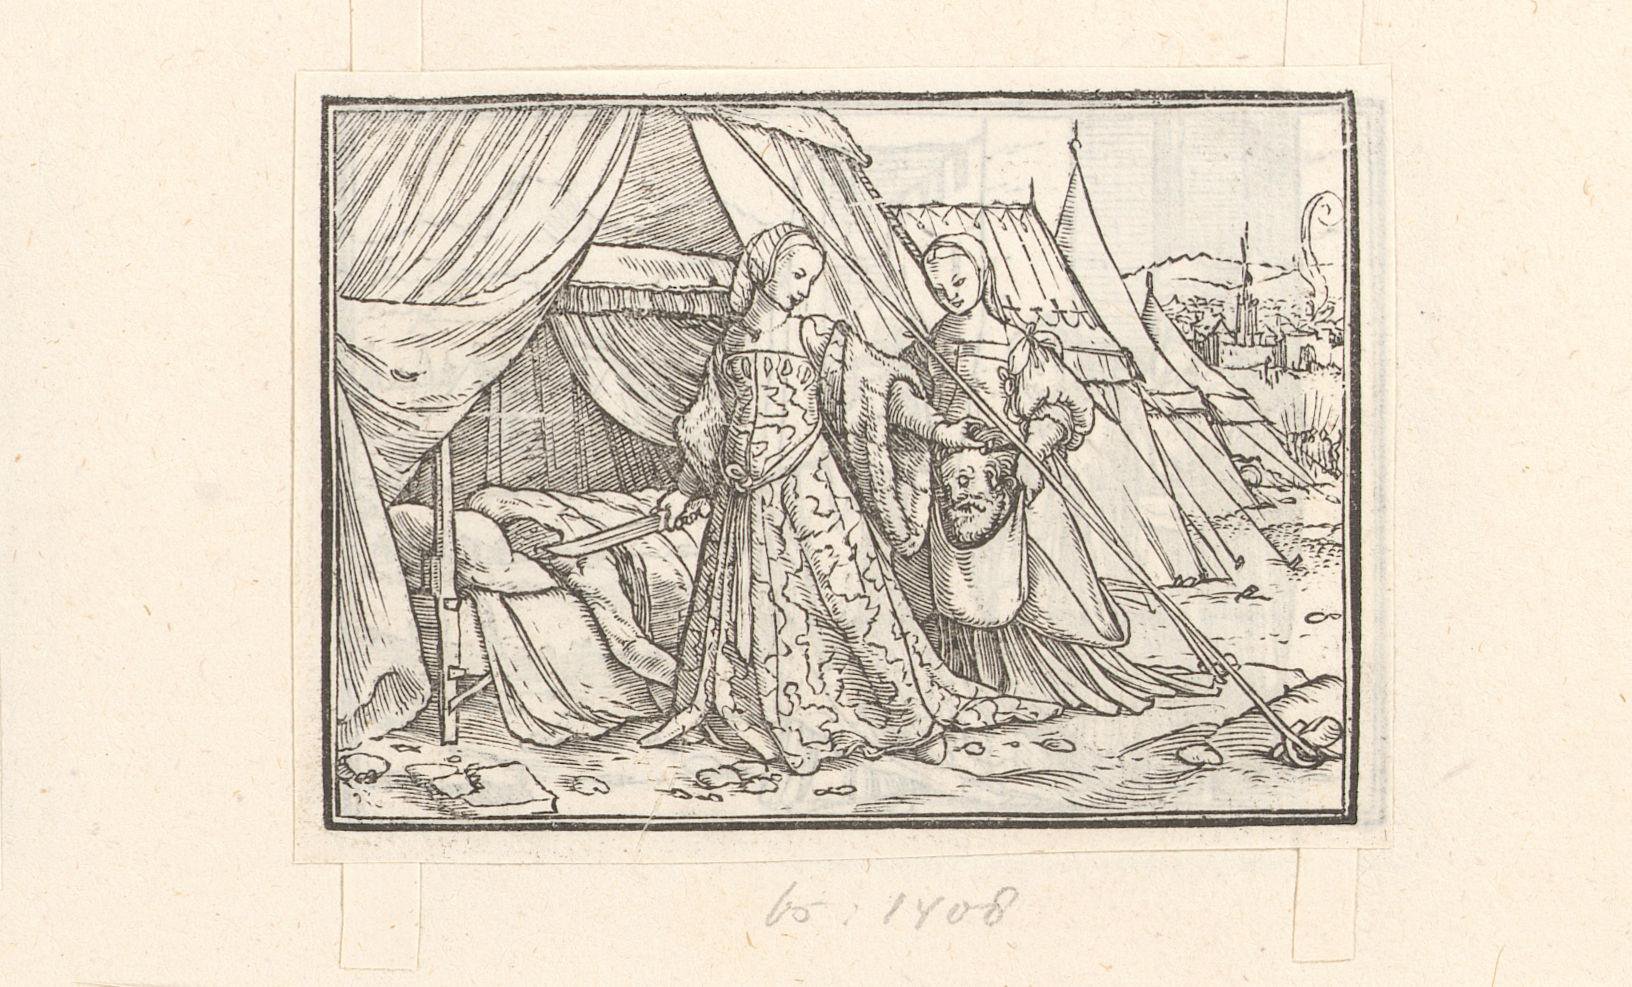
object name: book illustration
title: Geschiedenis van het Oude Testament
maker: veit rudolf specklin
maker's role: print maker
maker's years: -1550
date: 1538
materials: paper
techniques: woodcut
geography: switzerland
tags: judith and her maidservant put holofernes' head in a sack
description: Boekillustratie voor het eerst gebruikt in: Biblia Utriusque Testamenti iuxta Vulgatam Translationem, Lyon, M. en G. Trechsel (voor Hugo à Porta) 1538. Later in verschillende uitgaven opnieuw gebruikt. Deze prent vermoedelijk gebruikt in één van de uitgaven uitgegeven en/of gedrukt door Jean Frellon, Lyon.